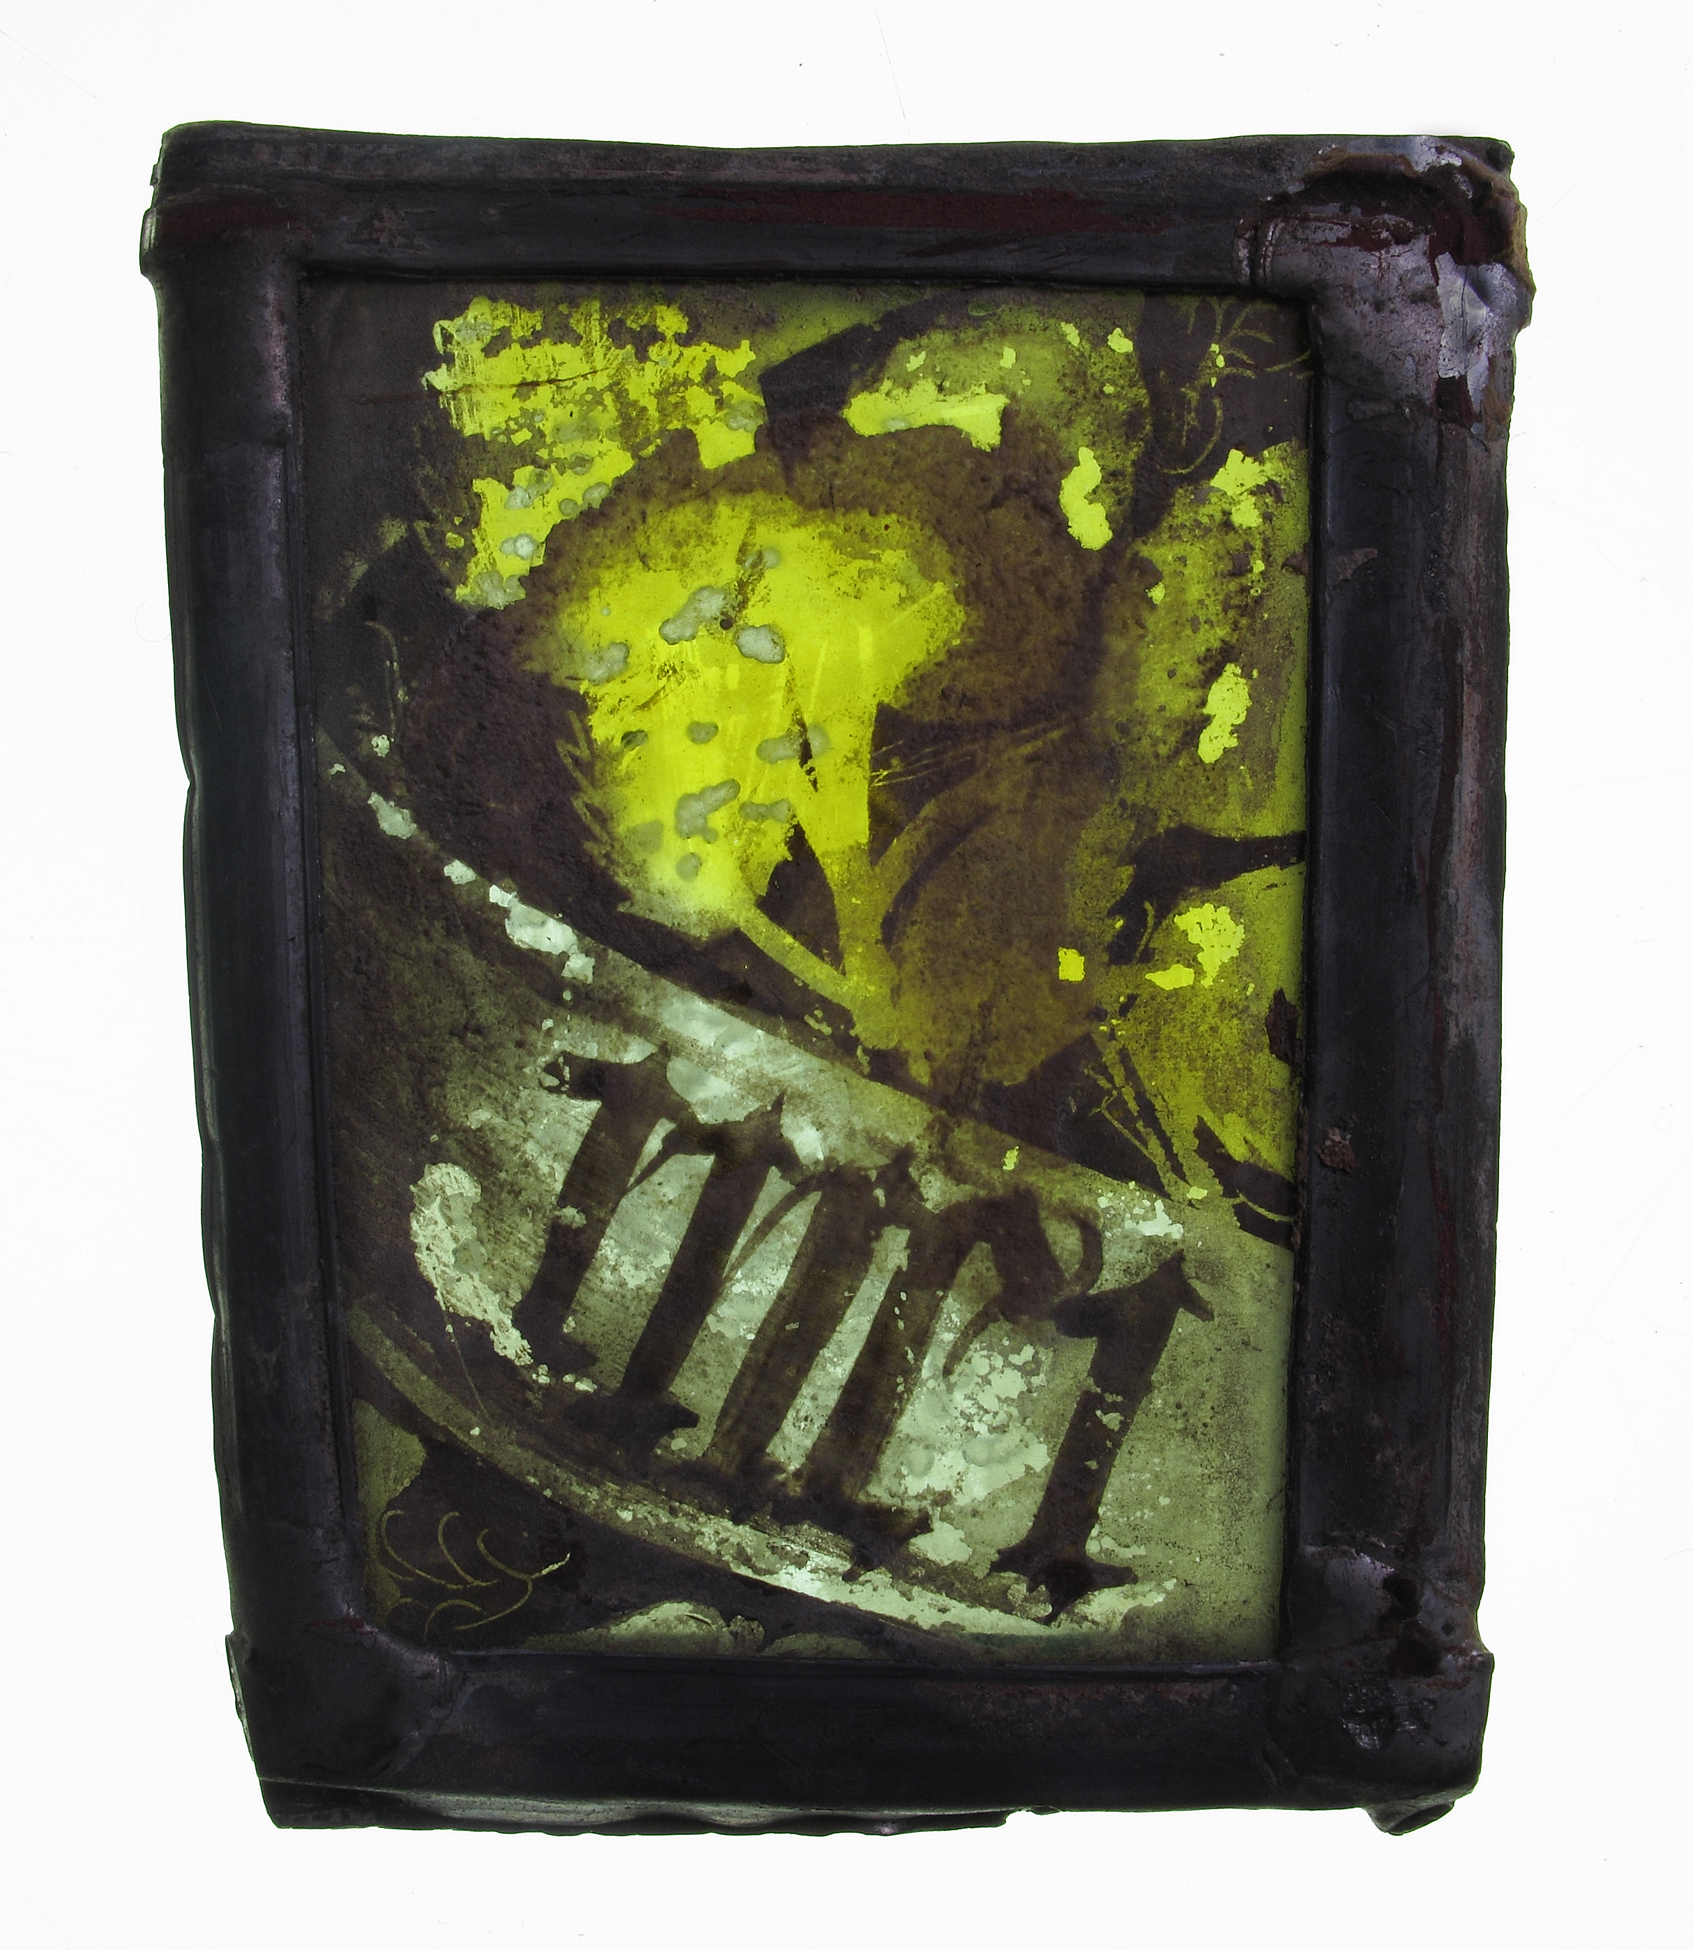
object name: fragment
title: Glass Fragment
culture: european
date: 1467-1500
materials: glass, pigment